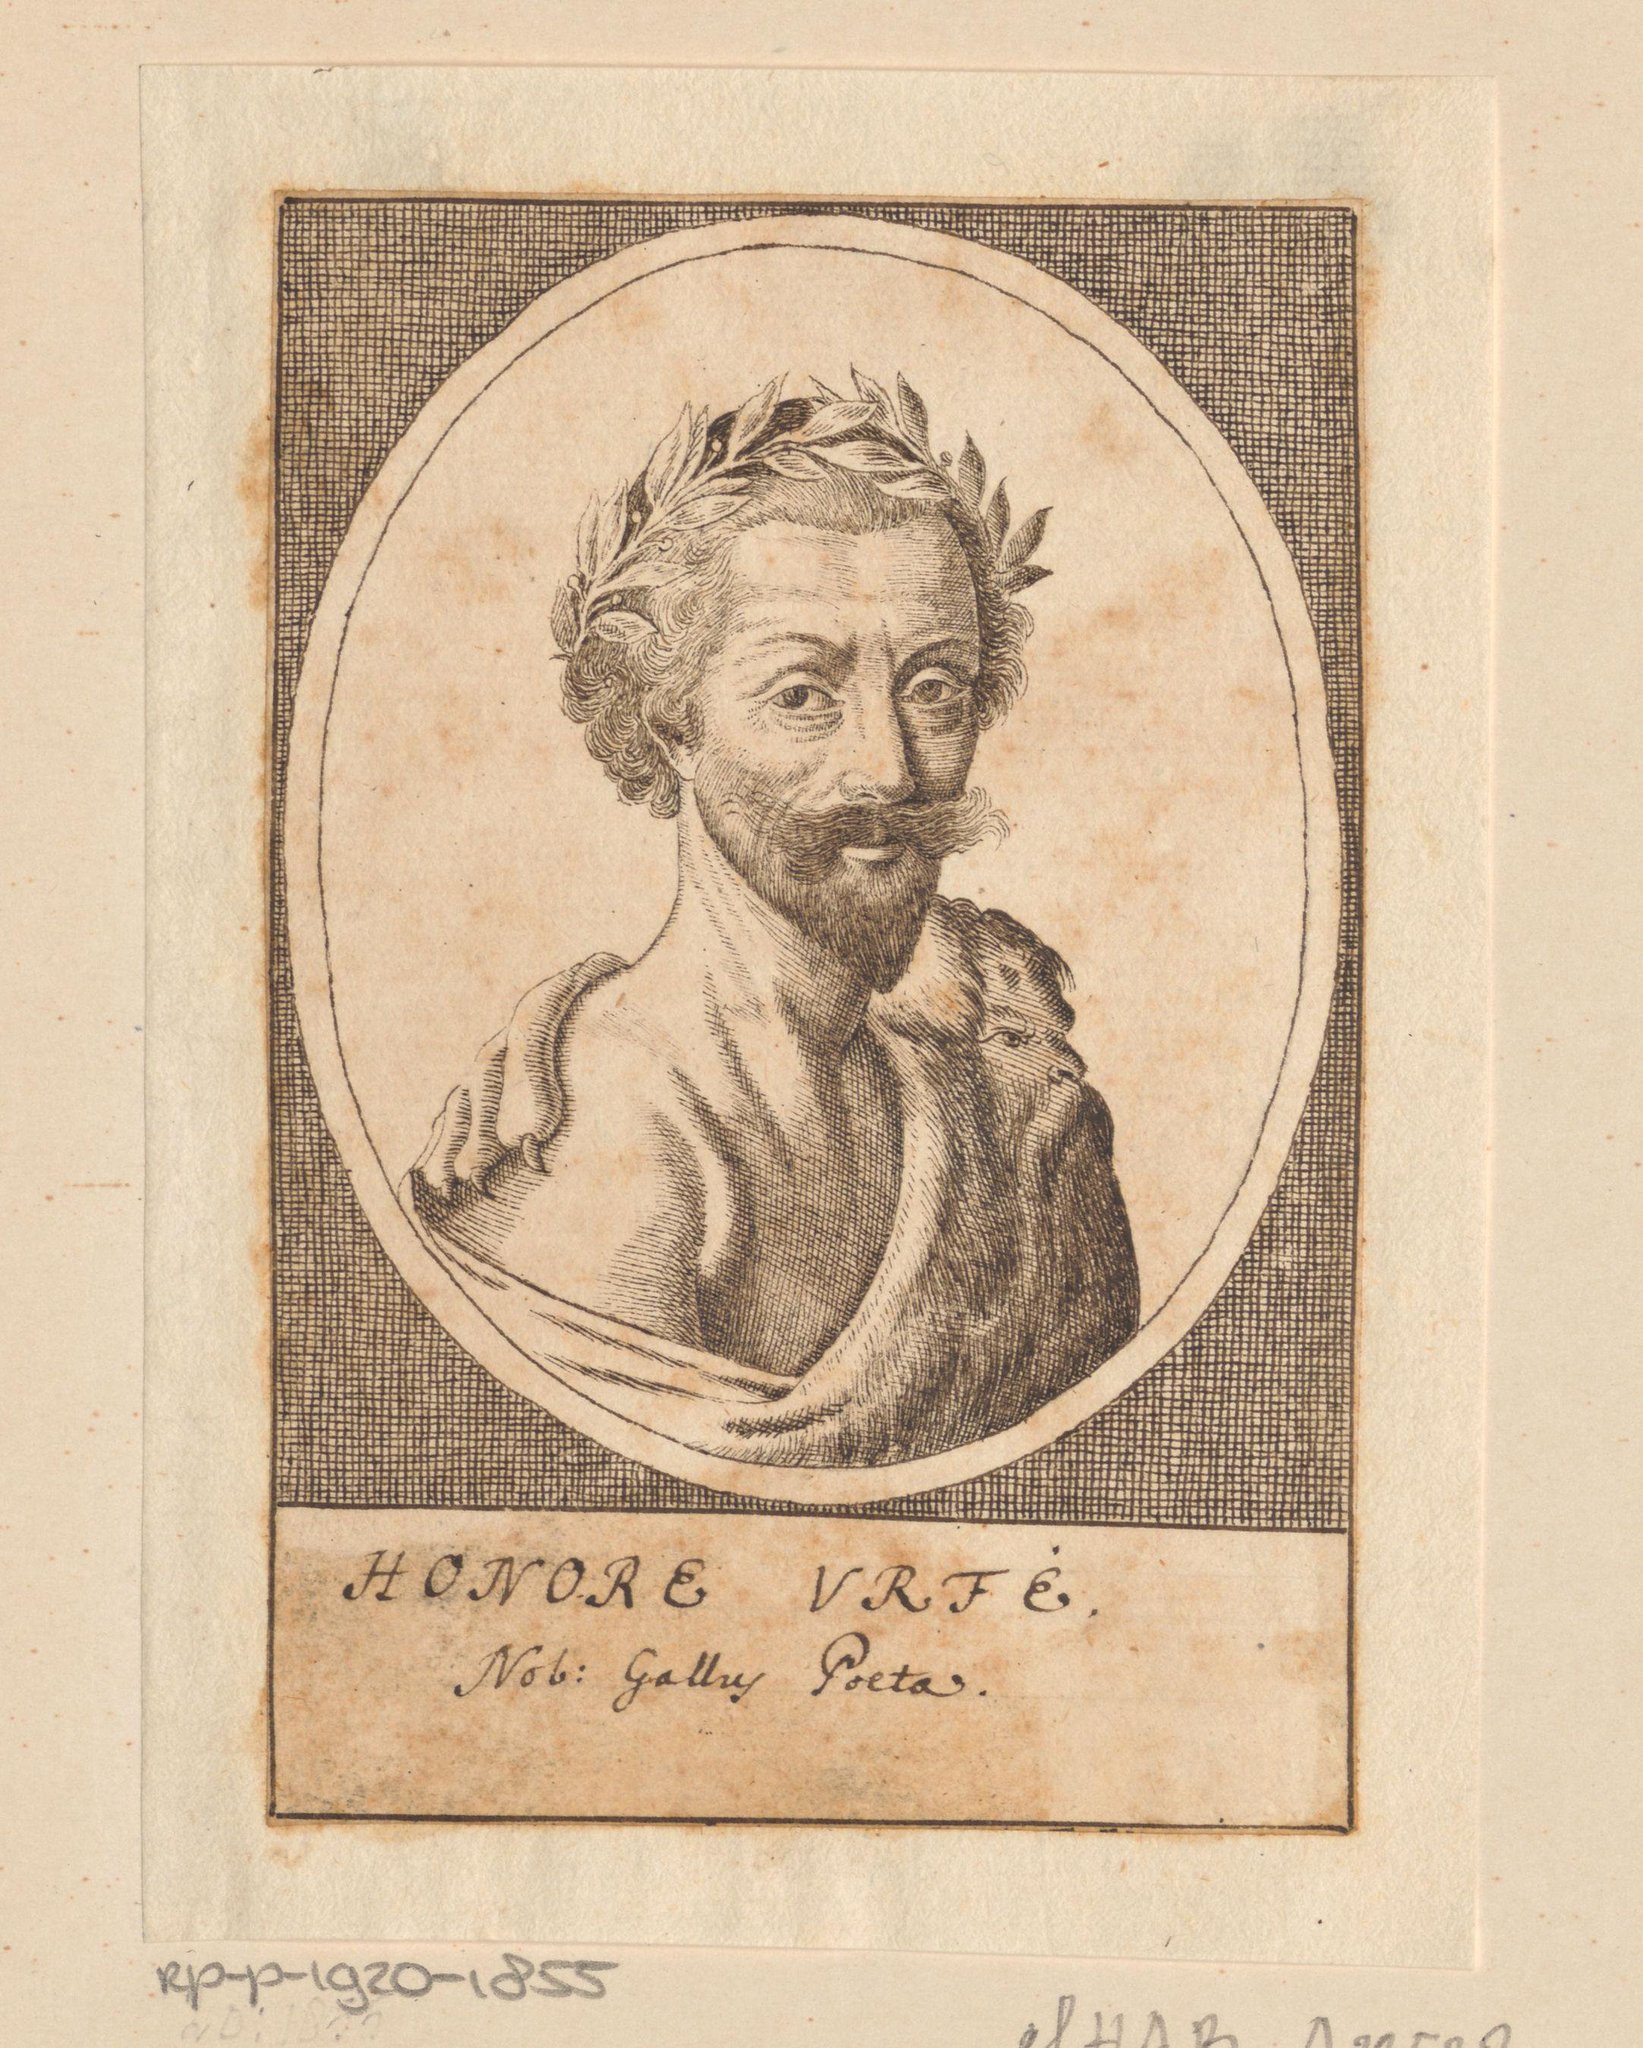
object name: print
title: Portret van Honoré D'Urfé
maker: Anonymous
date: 1600-1670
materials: paper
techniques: etching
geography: france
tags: historical persons, portrait of a writer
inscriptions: collector's mark: Lugt 2228